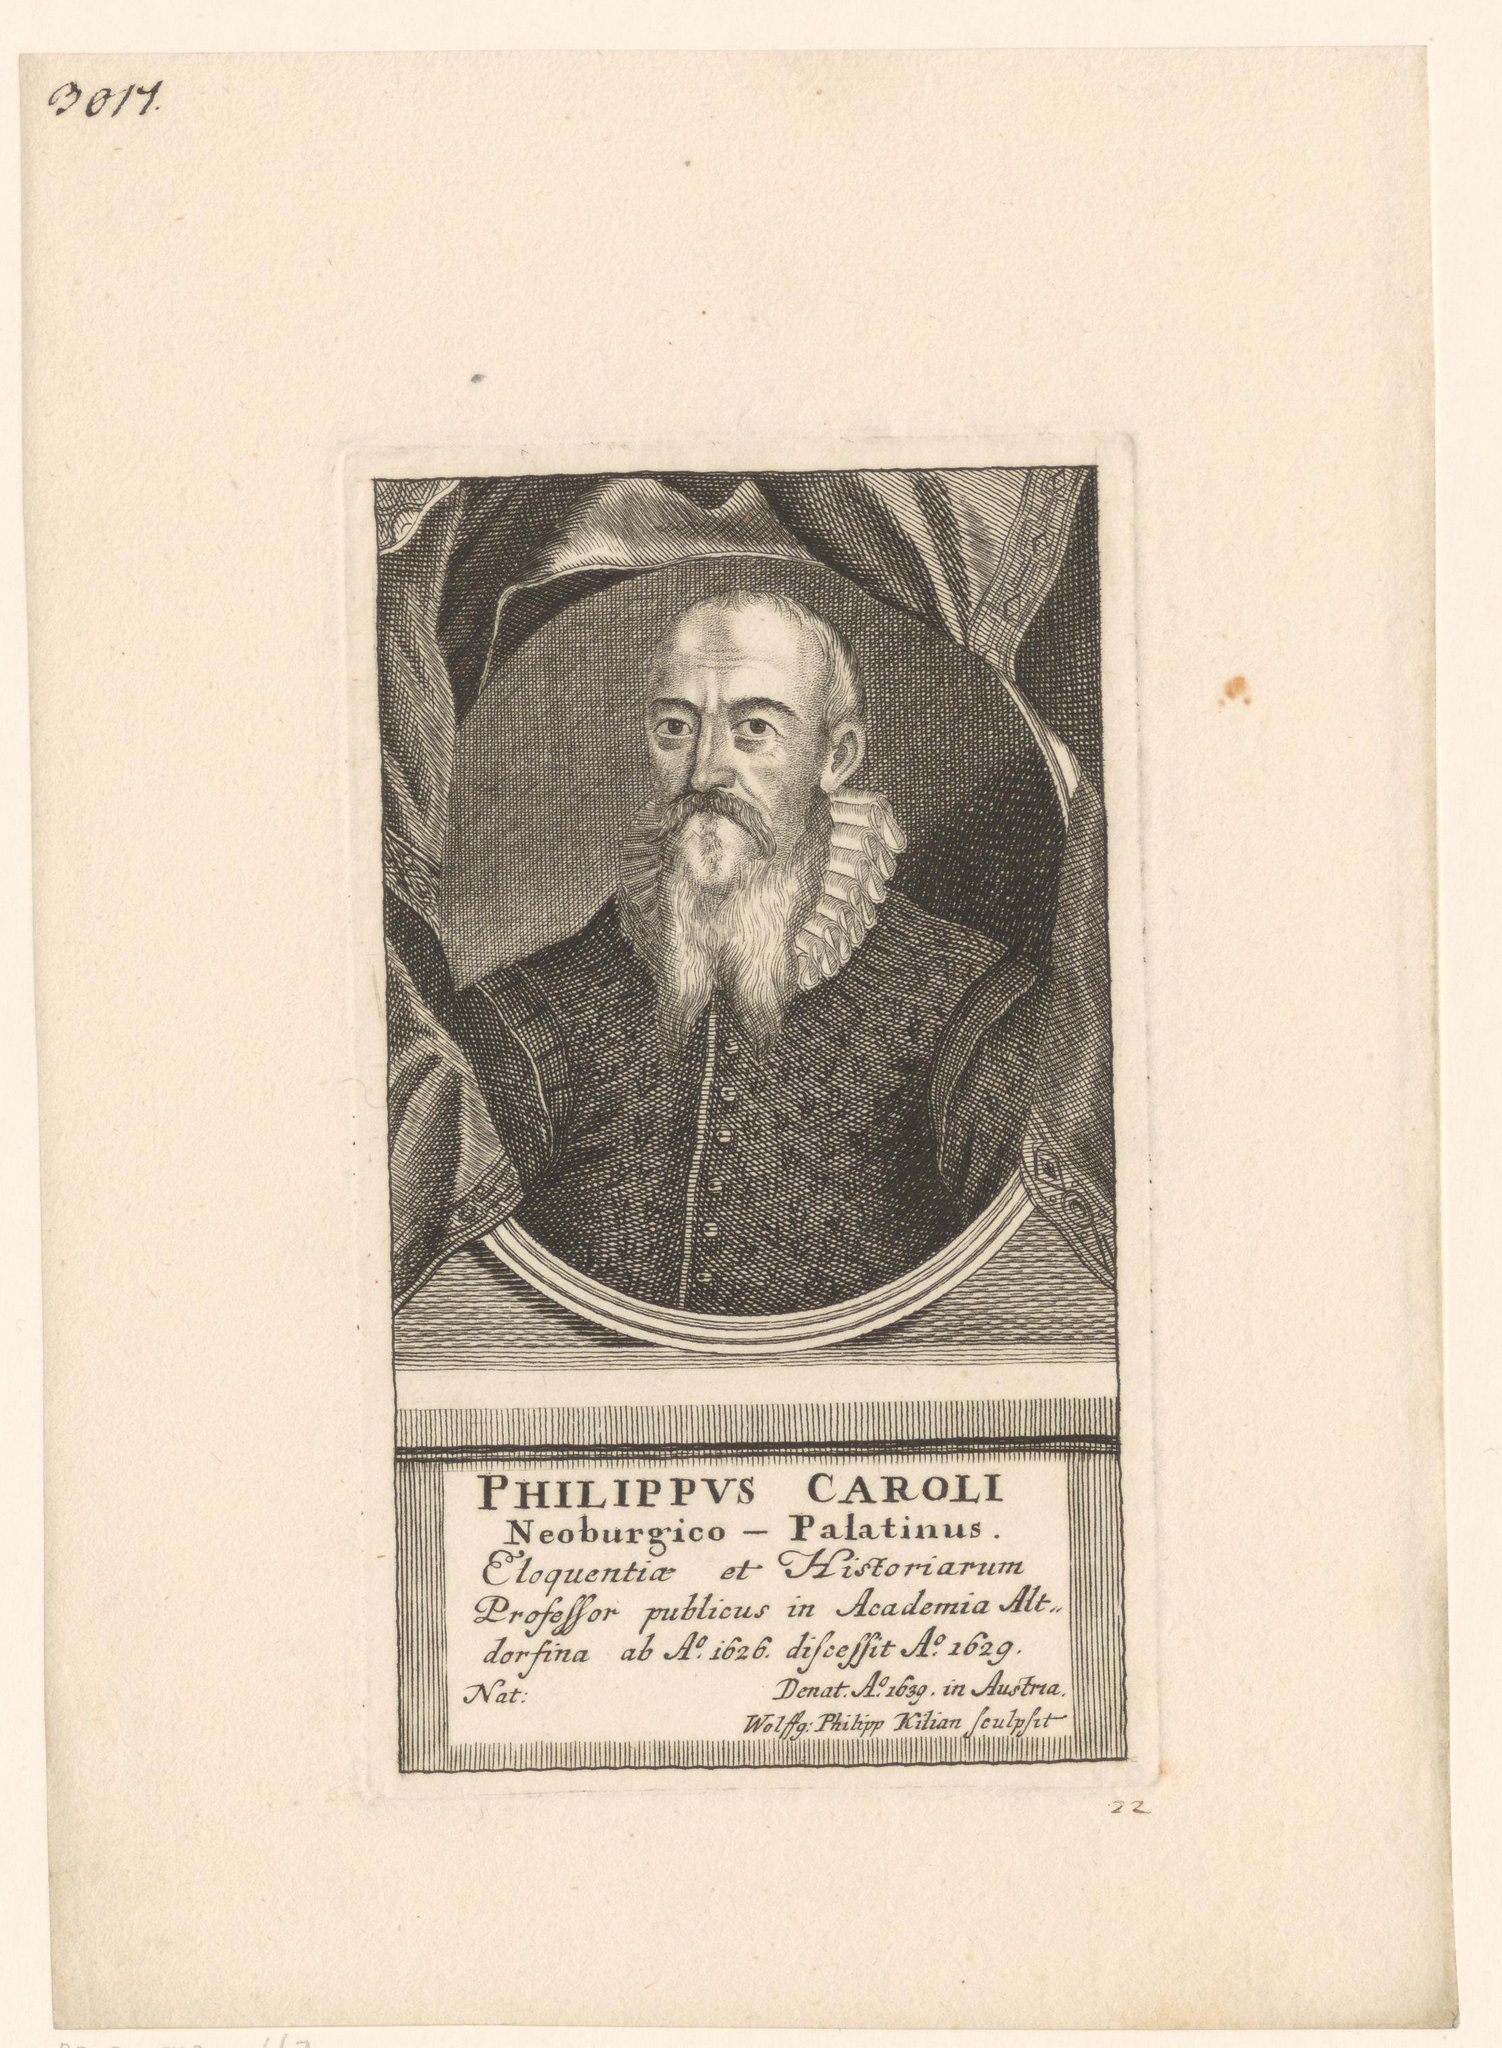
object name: print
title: Portret van Philipp Caroli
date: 1669-1728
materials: paper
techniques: engraving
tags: vienna, philology (+ portrait of scholar, scientist), further education (+ portrait of teacher, professor), historical persons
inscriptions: collector's mark: Lugt 2228, number: ‘22’